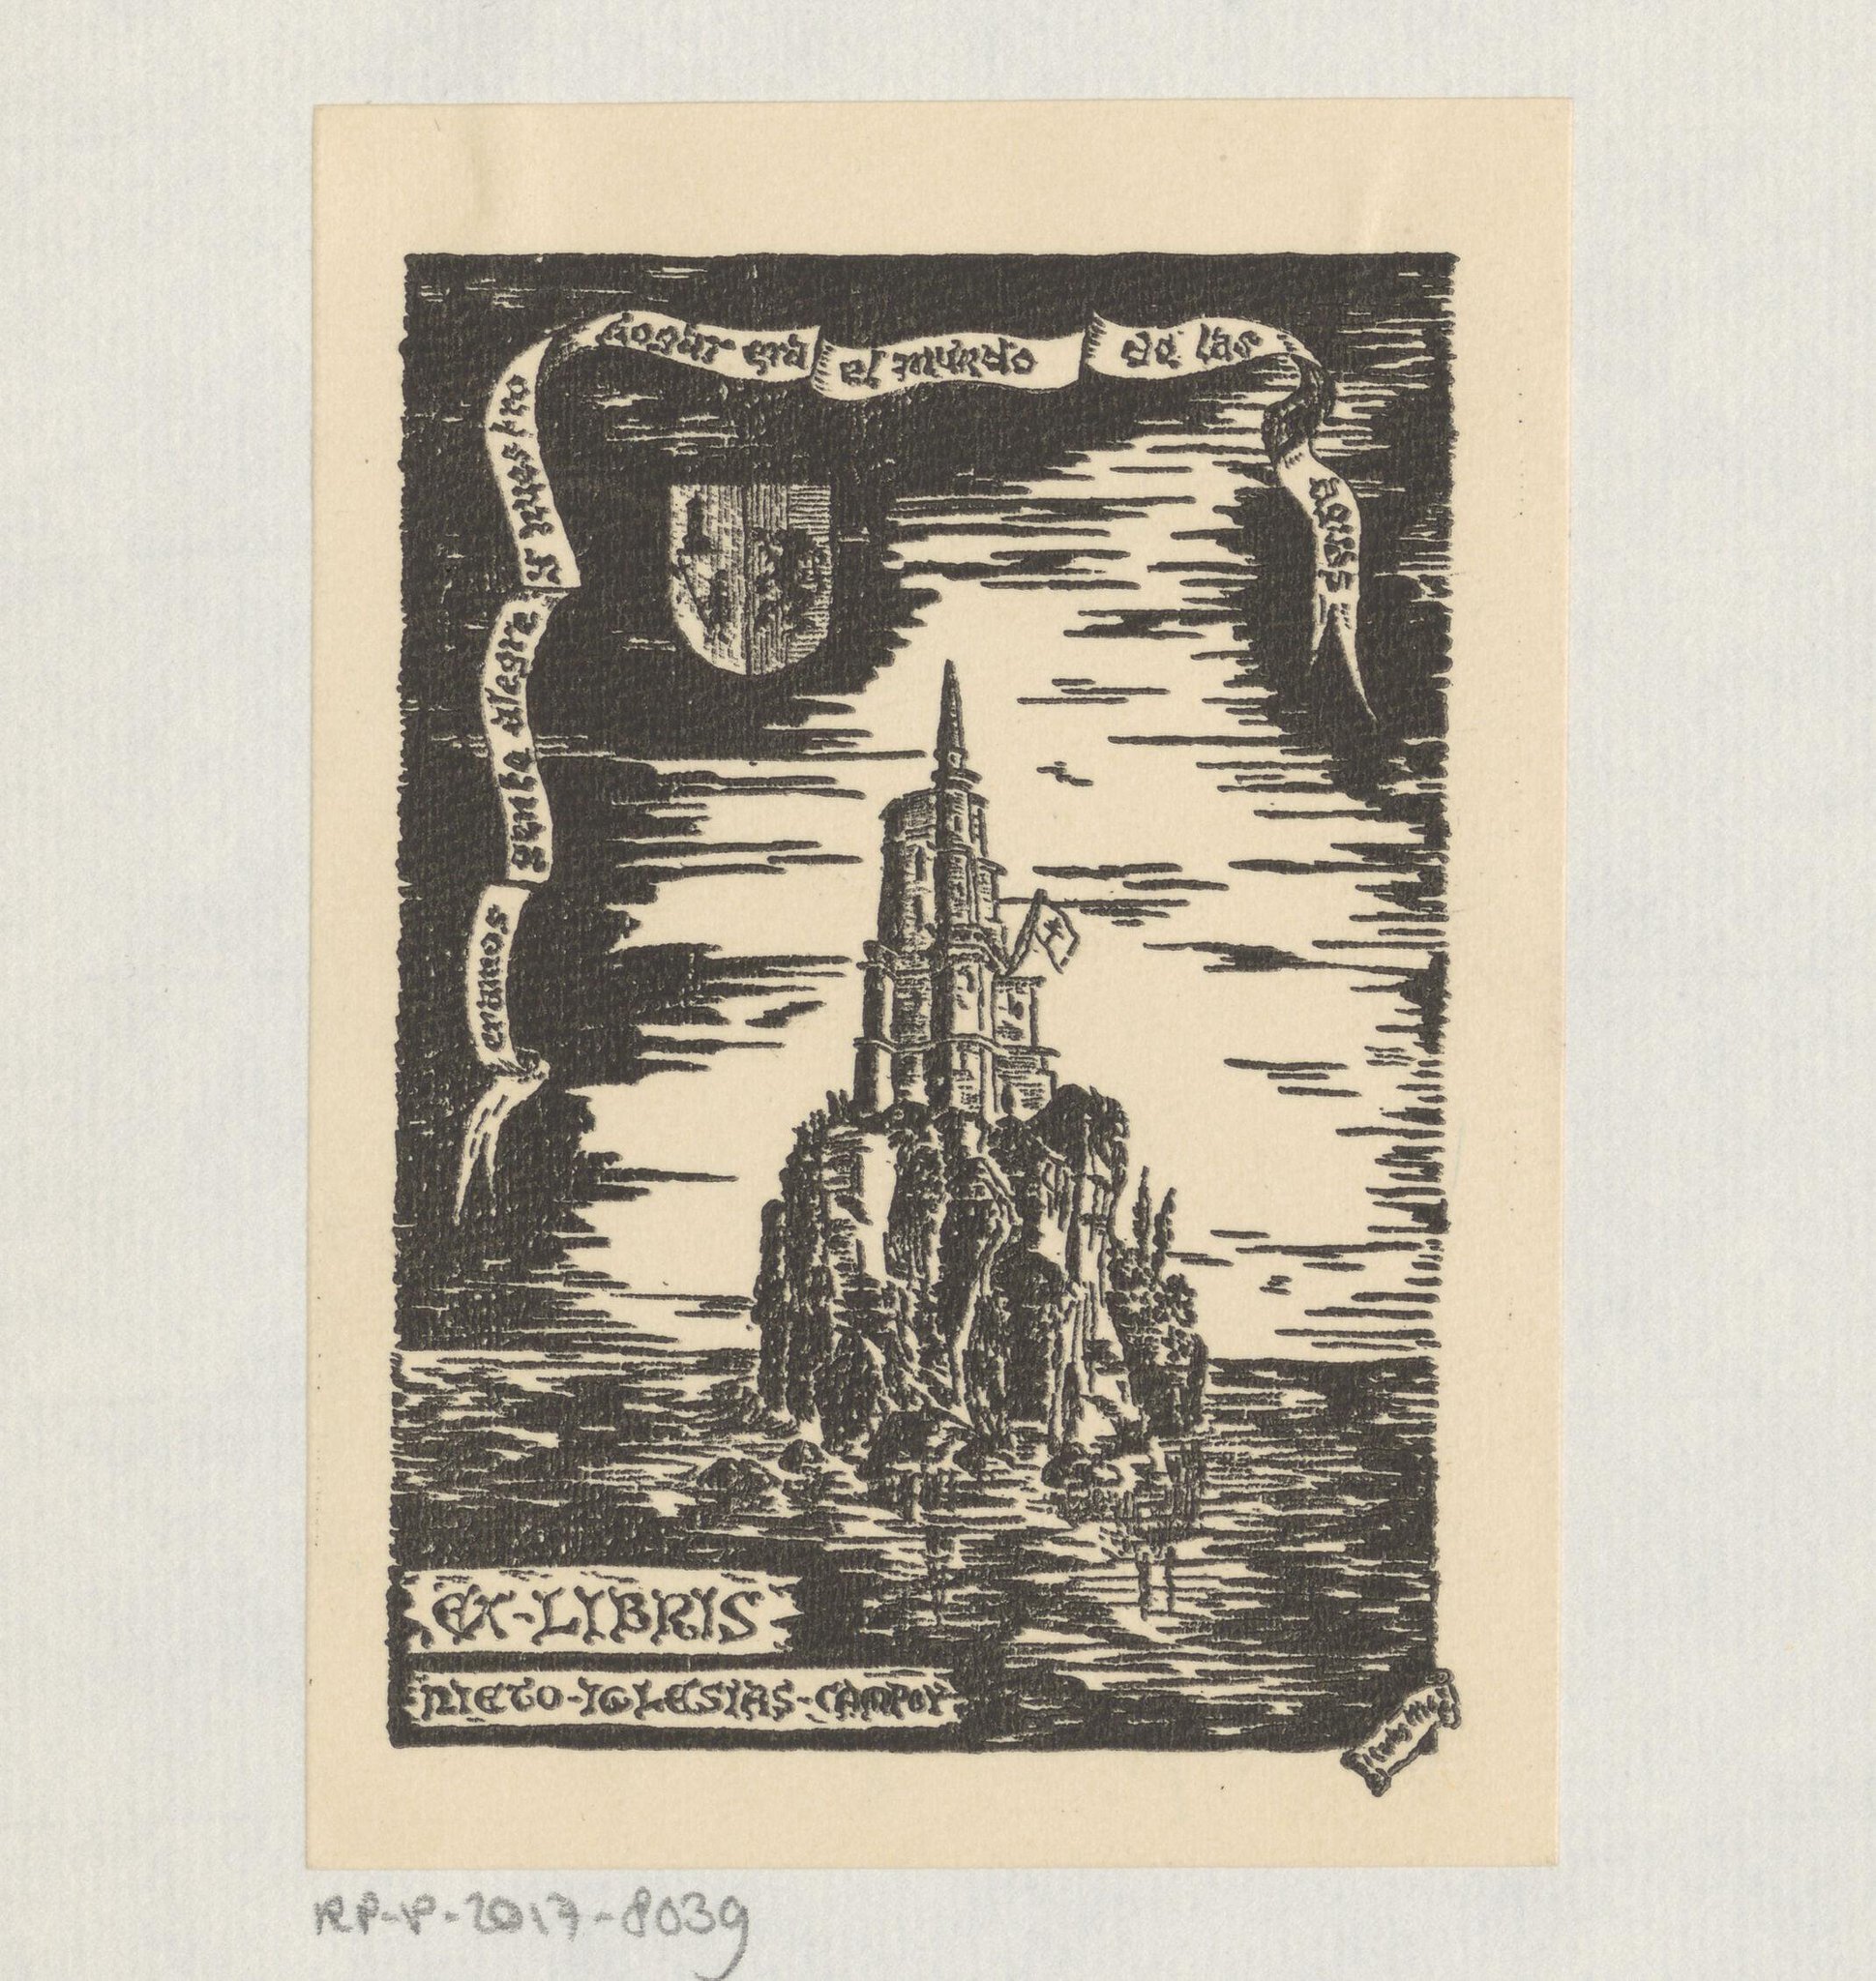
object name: bookplate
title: Ex libris, mogelijk van Nieto Iglesias Campoy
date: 1900-1949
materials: paper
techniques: printing block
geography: spain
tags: island, castle, armorial bearing, heraldry